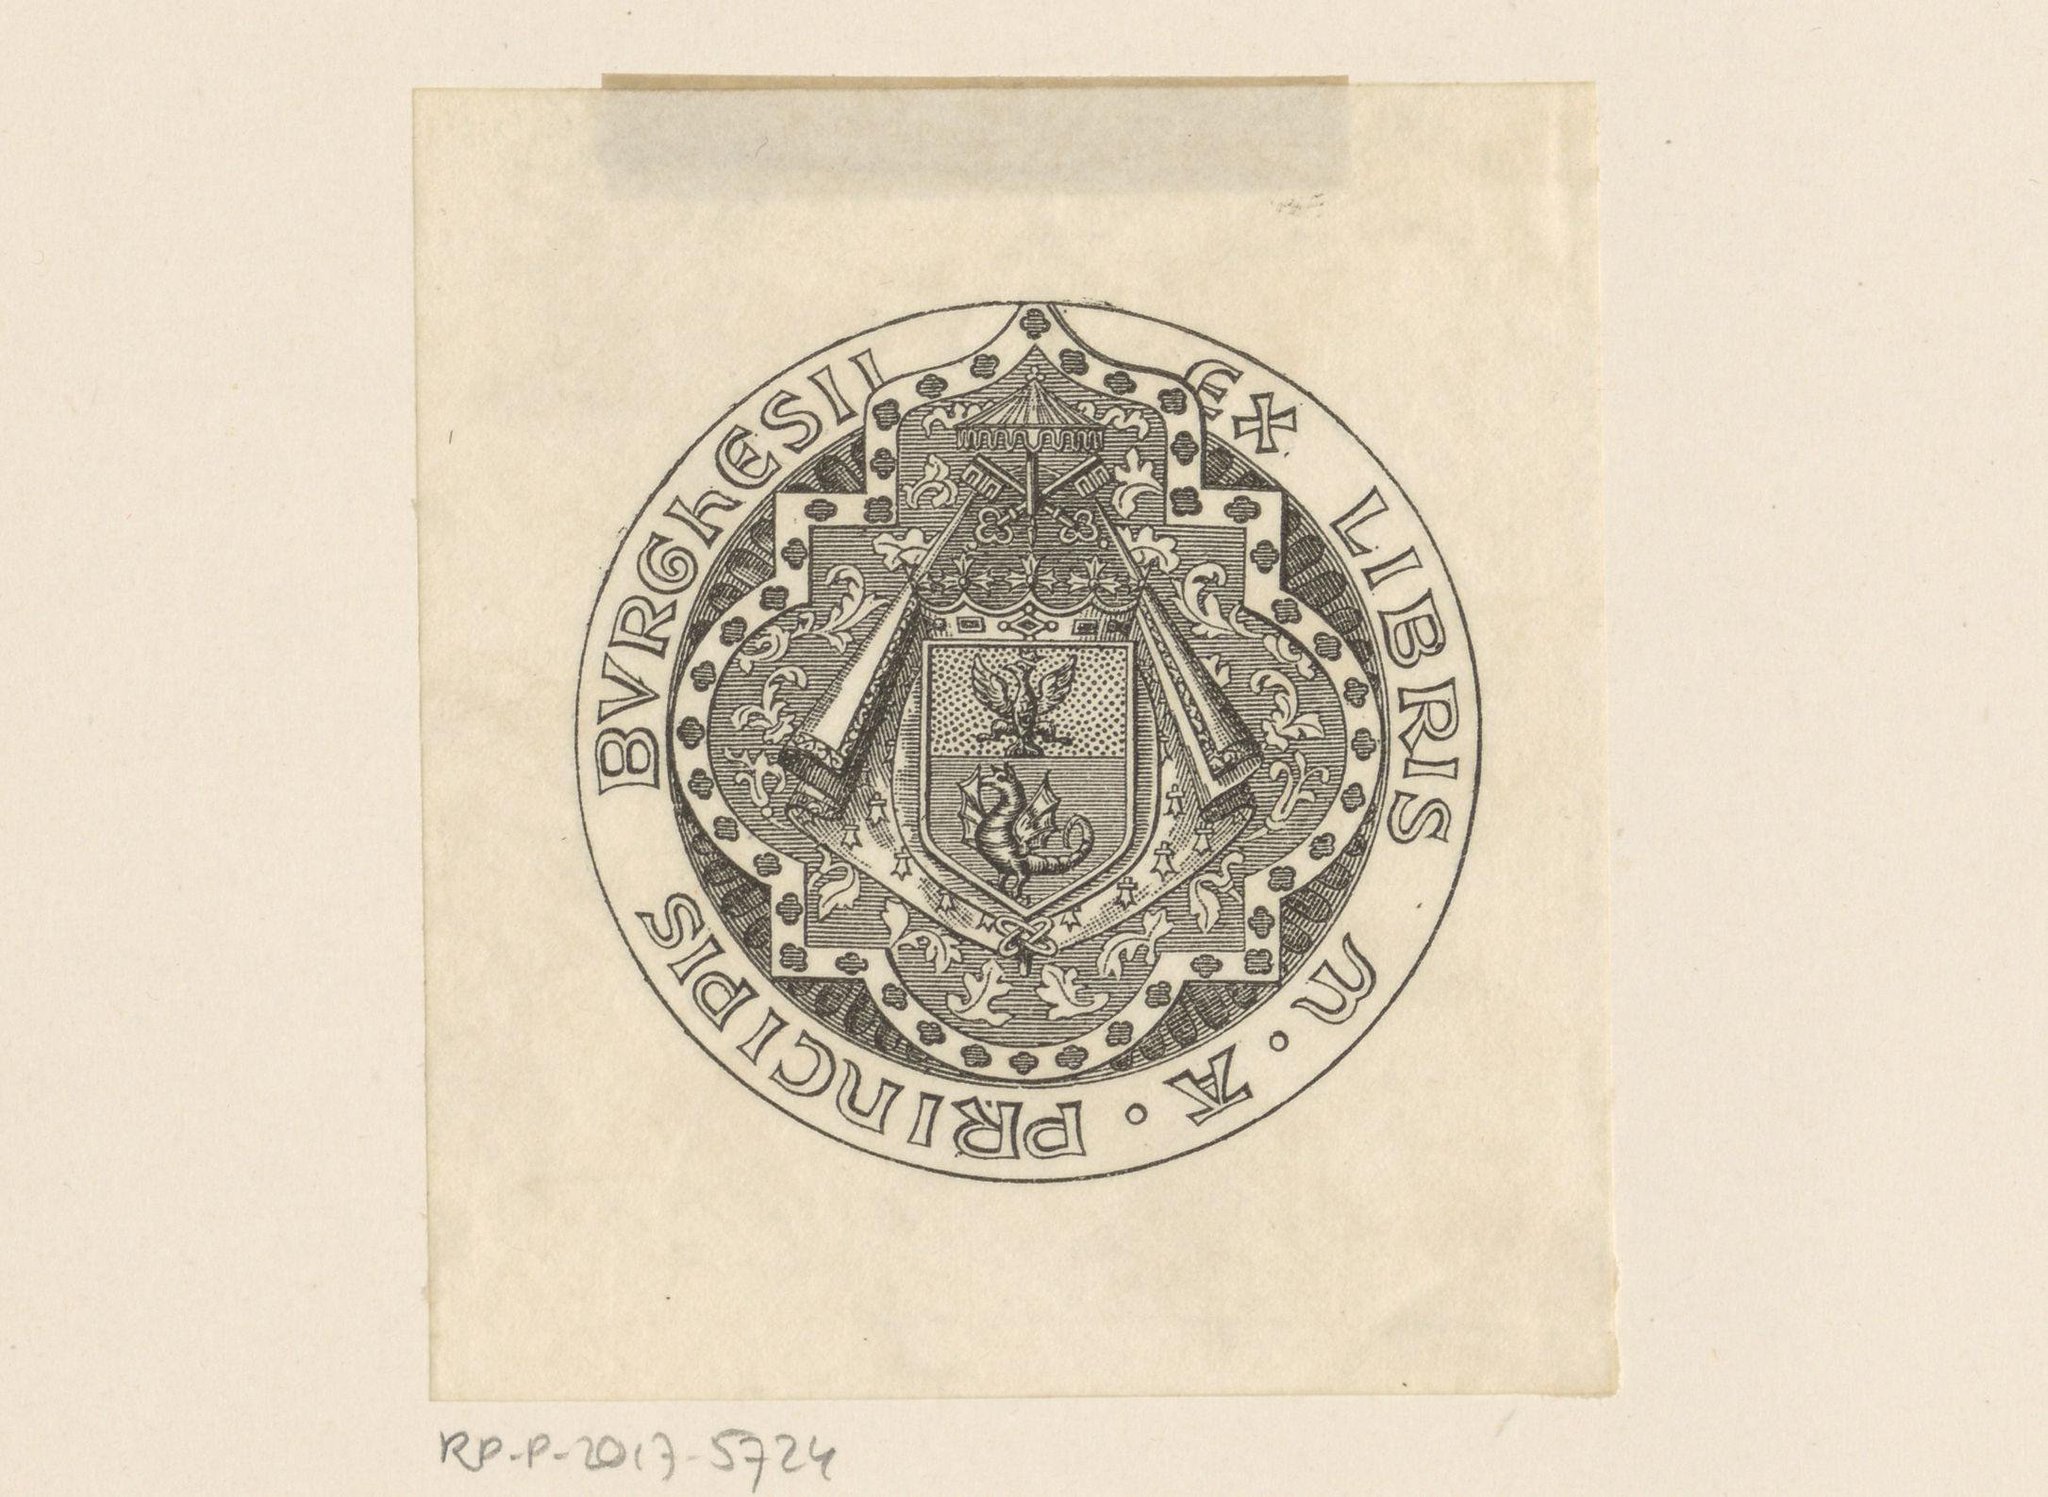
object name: bookplate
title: Ex libris M.A. principis Burghesii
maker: Anonymous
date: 1824-1886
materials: paper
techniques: printing block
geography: italy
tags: politician, armorial bearing, heraldry